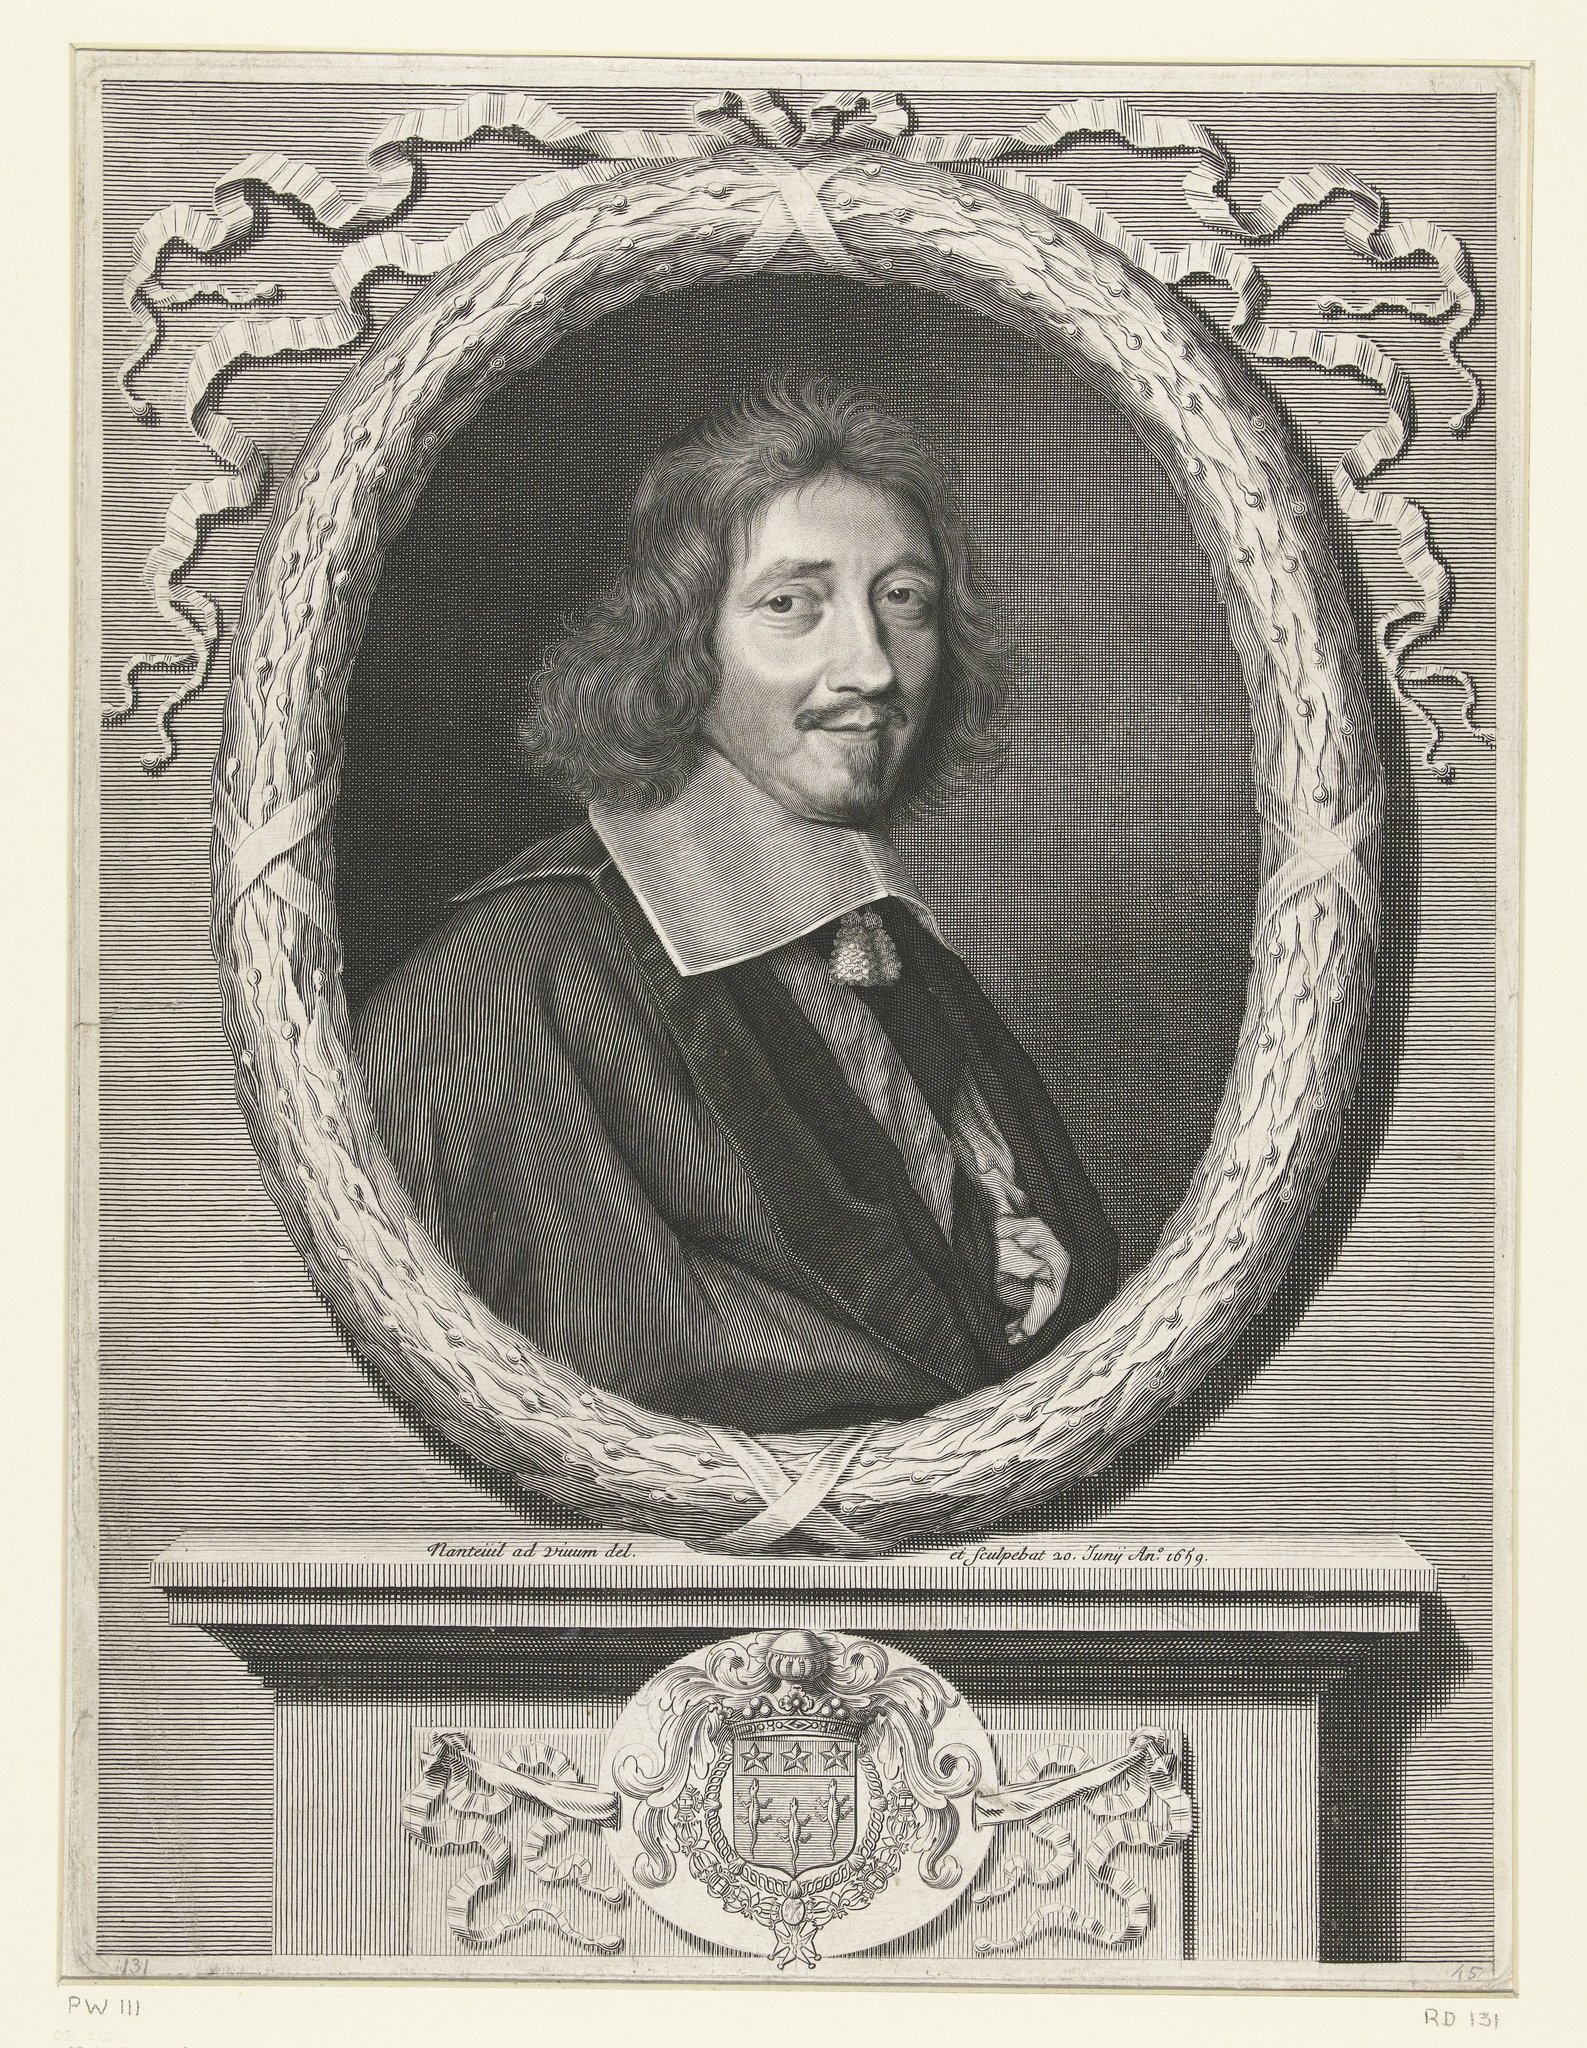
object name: print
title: Portret van Michel Le Tellier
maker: robert nanteuil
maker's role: print maker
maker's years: 1623-1678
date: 1659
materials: paper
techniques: engraving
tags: michel le tellier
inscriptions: collector's mark: Lugt 240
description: Portret van kanselier Michel Le Tellier, in een ovale lauwerkrans met linten. Op de sokkel een wapenschild.